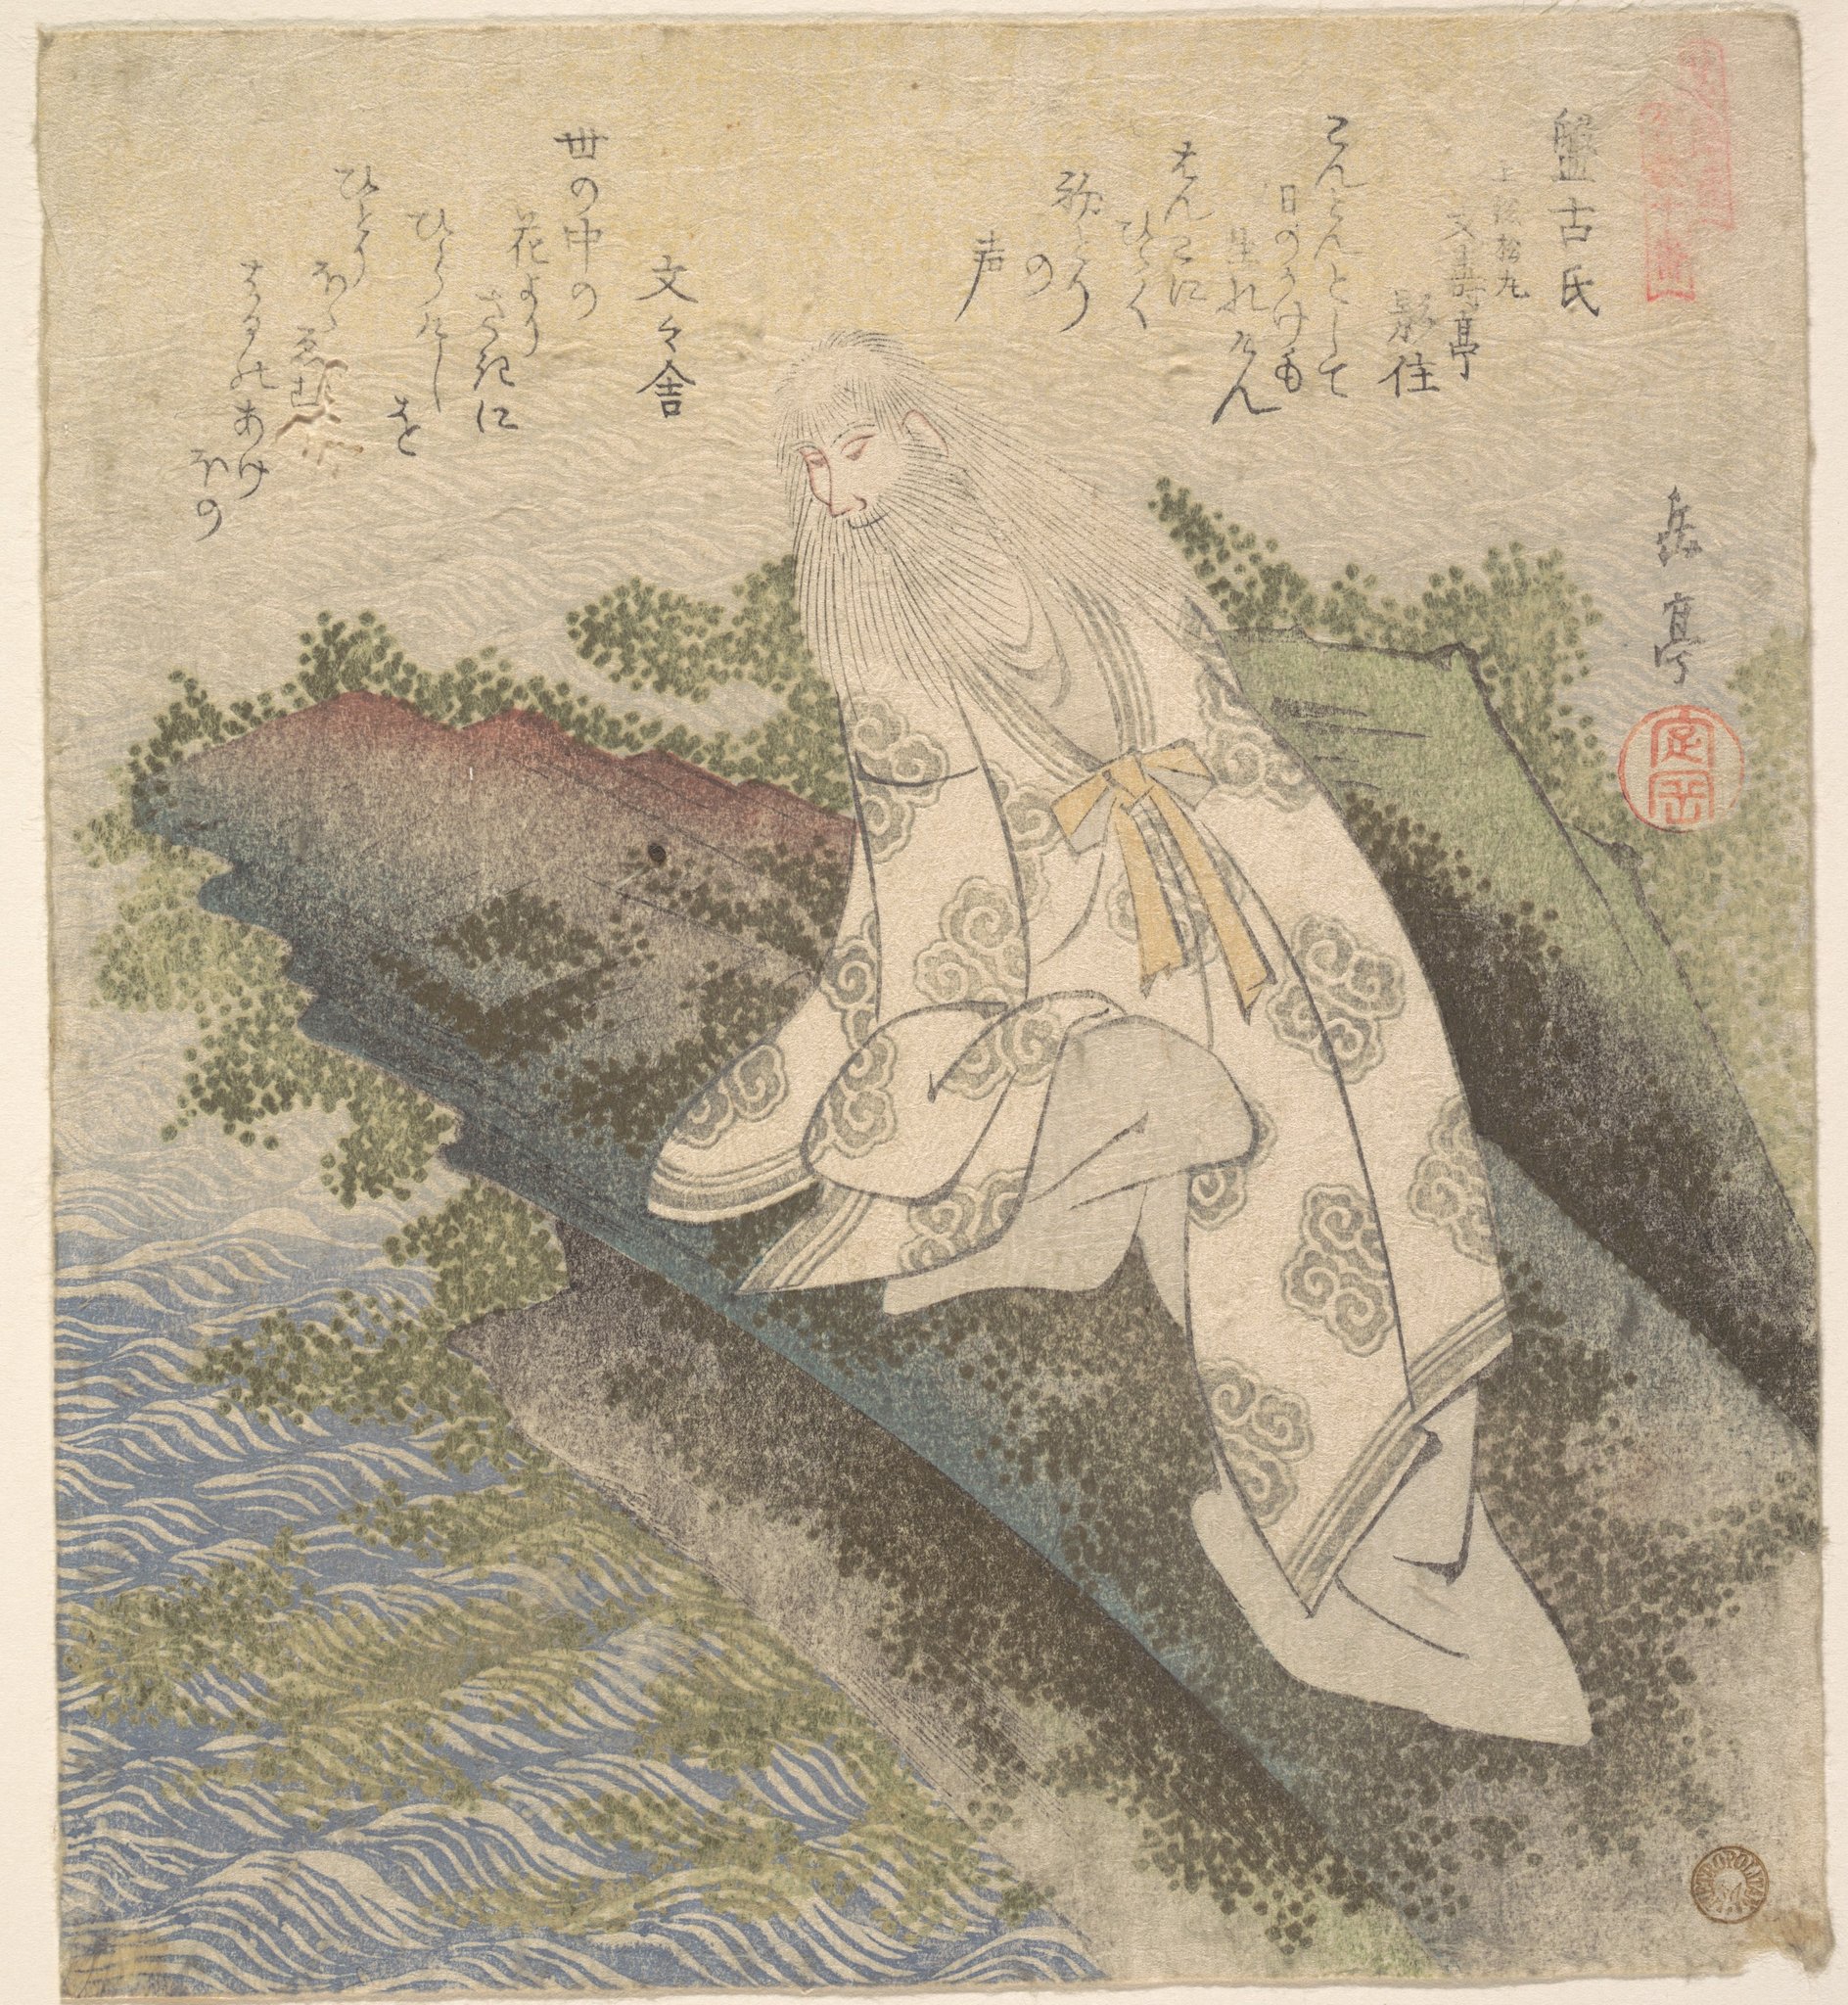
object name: print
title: Banko, a Chinese Sage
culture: japanese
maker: yashima gakutei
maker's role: artist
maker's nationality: japanese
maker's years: 1786-1868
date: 1801-1900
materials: ink, paper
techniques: surimono, woodblock print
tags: men